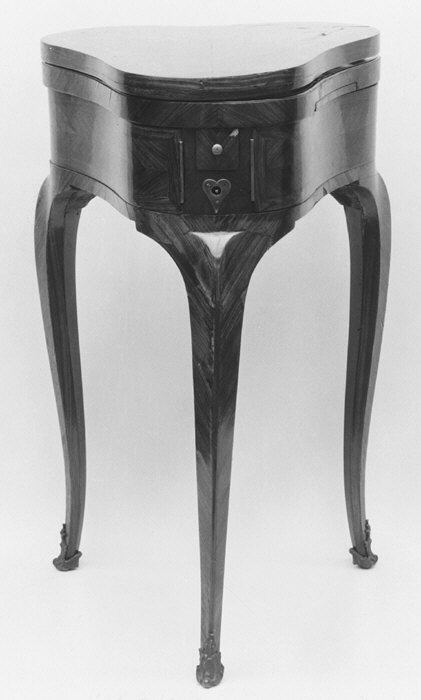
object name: table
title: Table (poudreuse)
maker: germain landrin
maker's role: maker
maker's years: 1710-1785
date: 1701-1800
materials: gilt bronze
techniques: veneering